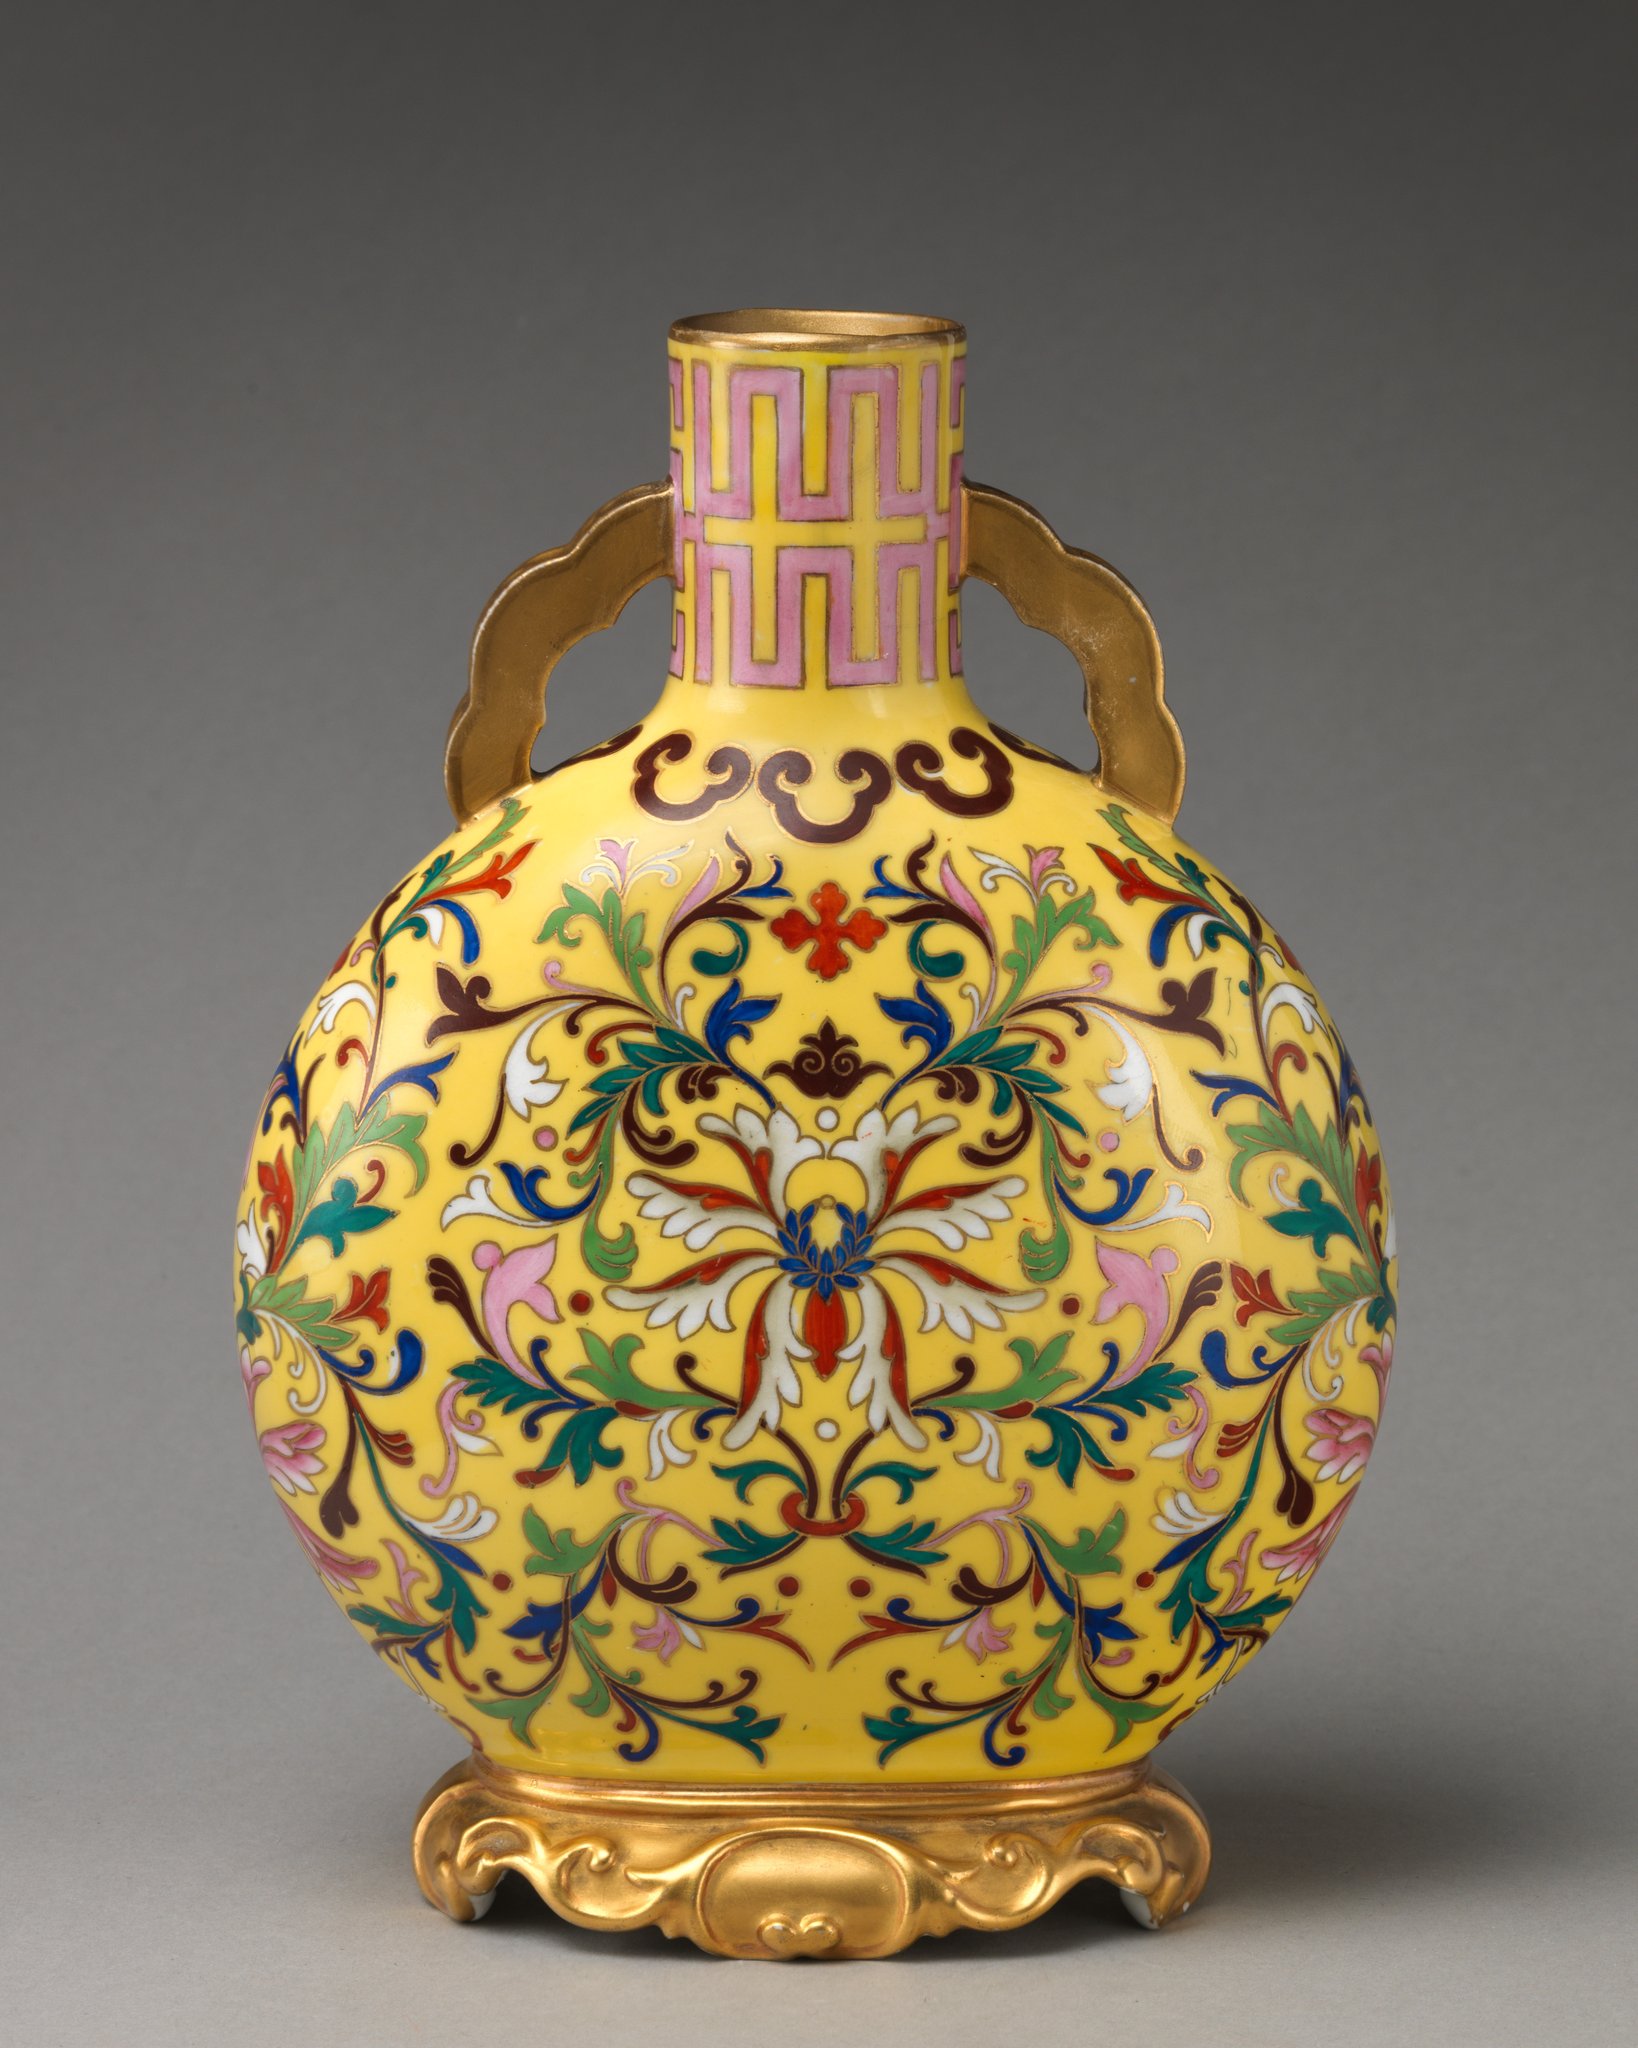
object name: moon flask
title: Yellow moon flask with "cloisonné" decoration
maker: worcester factory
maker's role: maker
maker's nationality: british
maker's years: 1751-2008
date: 1870-1879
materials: bone china, enamel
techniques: gilding